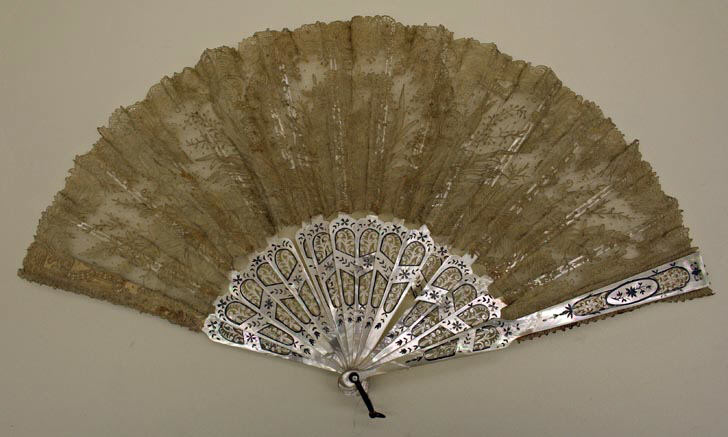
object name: fan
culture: french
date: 1890-1899